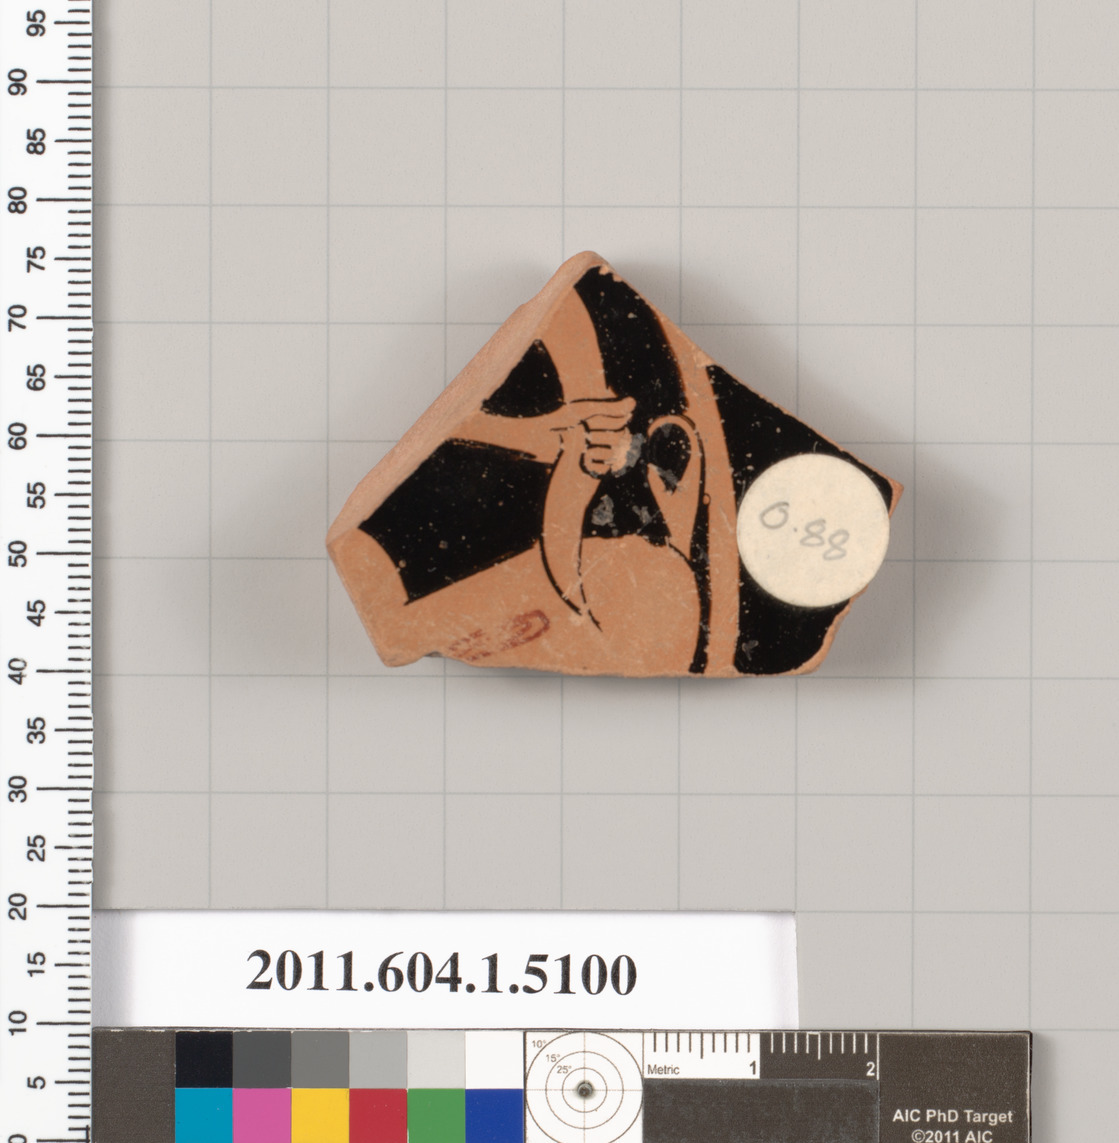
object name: kylix fragment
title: Terracotta fragment of a kylix (drinking cup)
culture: greek, attic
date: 510-490 BCE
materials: terracotta